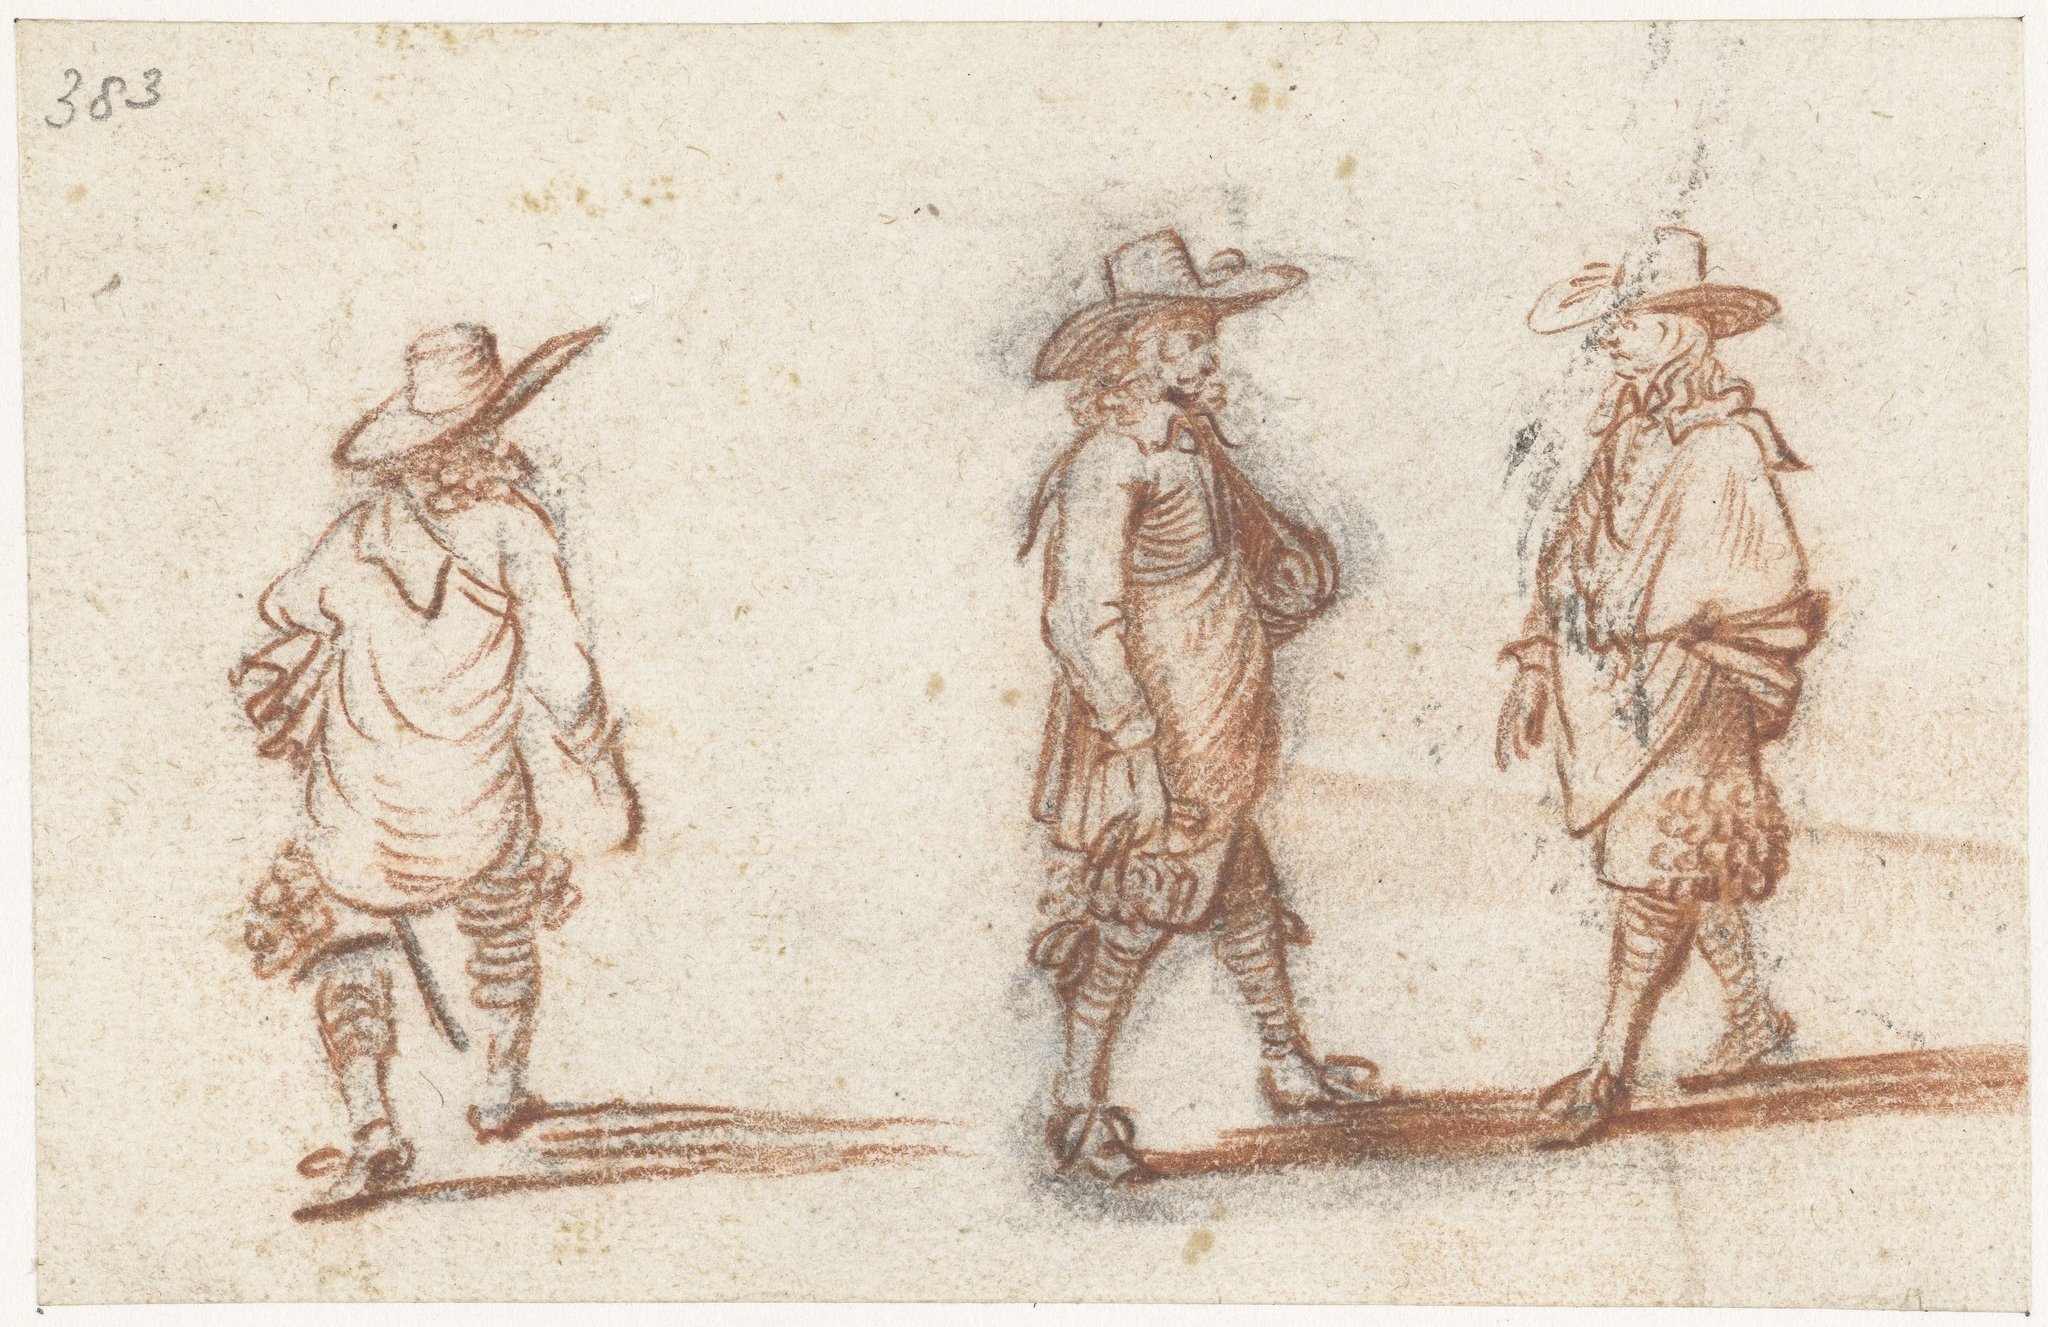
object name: drawing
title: Study Sheet with Three Views of a Gentleman Walking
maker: gesina ter borch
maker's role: draughtsman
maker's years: 1633-1690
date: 1661-1669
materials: chalk, paper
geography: zwolle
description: A fashionably dressed man is depicted from three different sides. Ter Borch first made cursory sketches in black chalk and then added contours and details in red chalk. Such study sheets without a narrative composition are rare in Ter Borch’s oeuvre and afford insight into her working methods. This sheet underscores her interest in natural poses and correctly rendered clothing, as seen elsewhere in her work.